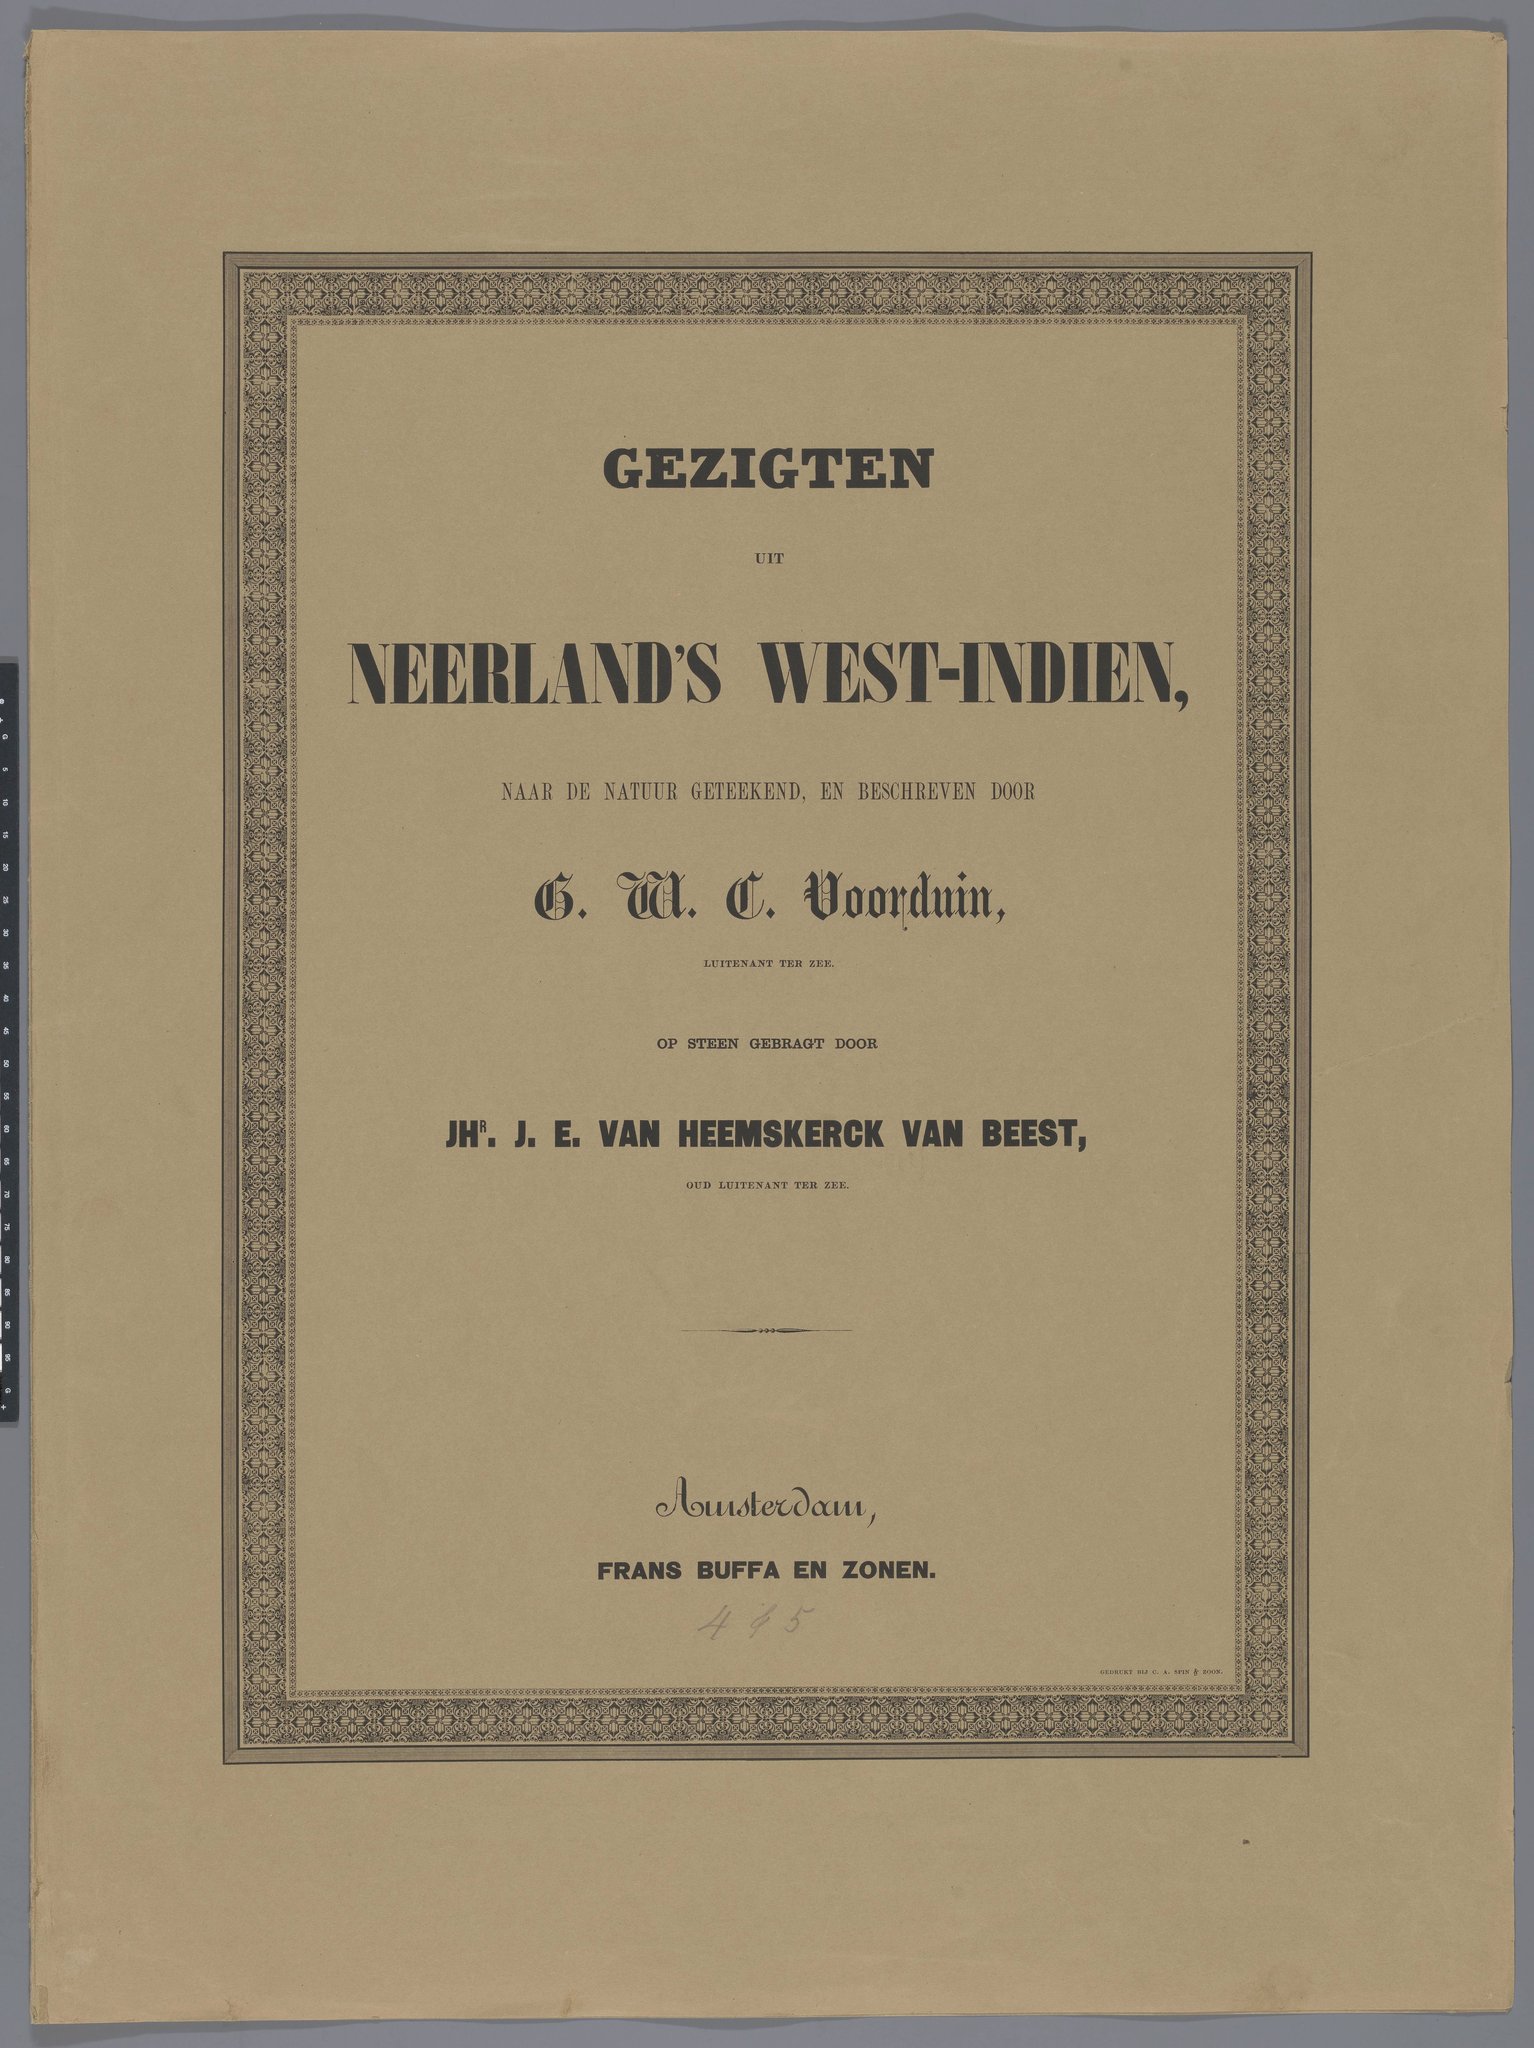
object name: print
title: Gezigten uit Neerland's West-Indien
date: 1860-1862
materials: paper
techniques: lithograph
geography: amsterdam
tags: title-page, suriname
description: Omslag met zeventien lithografieën met voorstellingen van Suriname en de Nederlandse Antillen. Rondom de tekst op de omslag een ornamentrand.